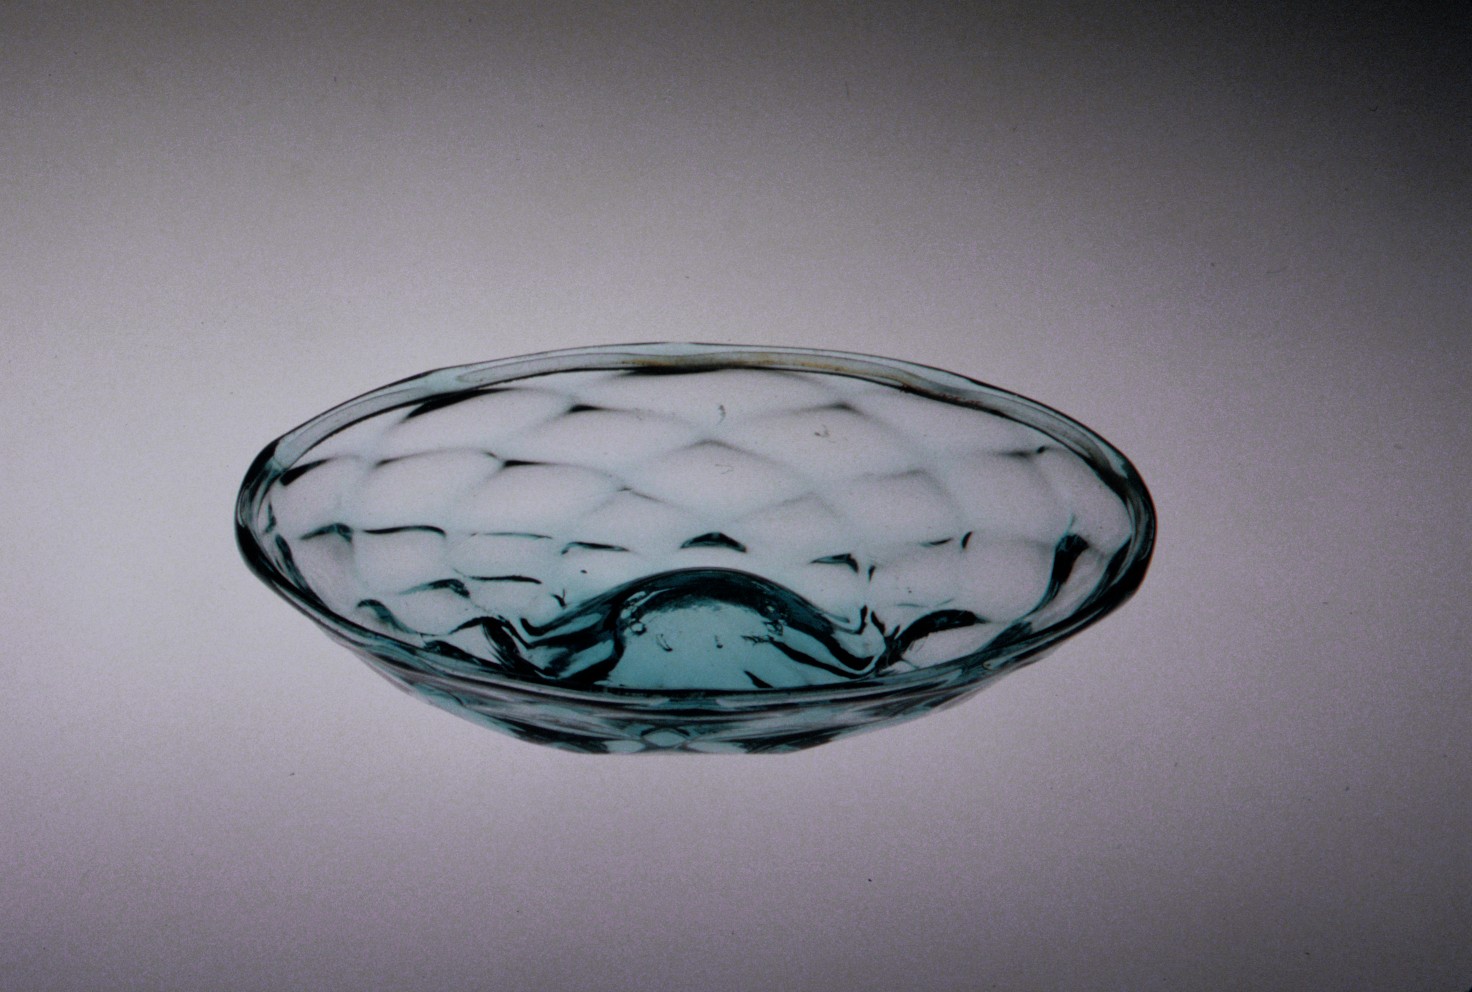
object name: pan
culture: american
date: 1800-1860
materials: gemstone, glass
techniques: glassblowing, molding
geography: united states